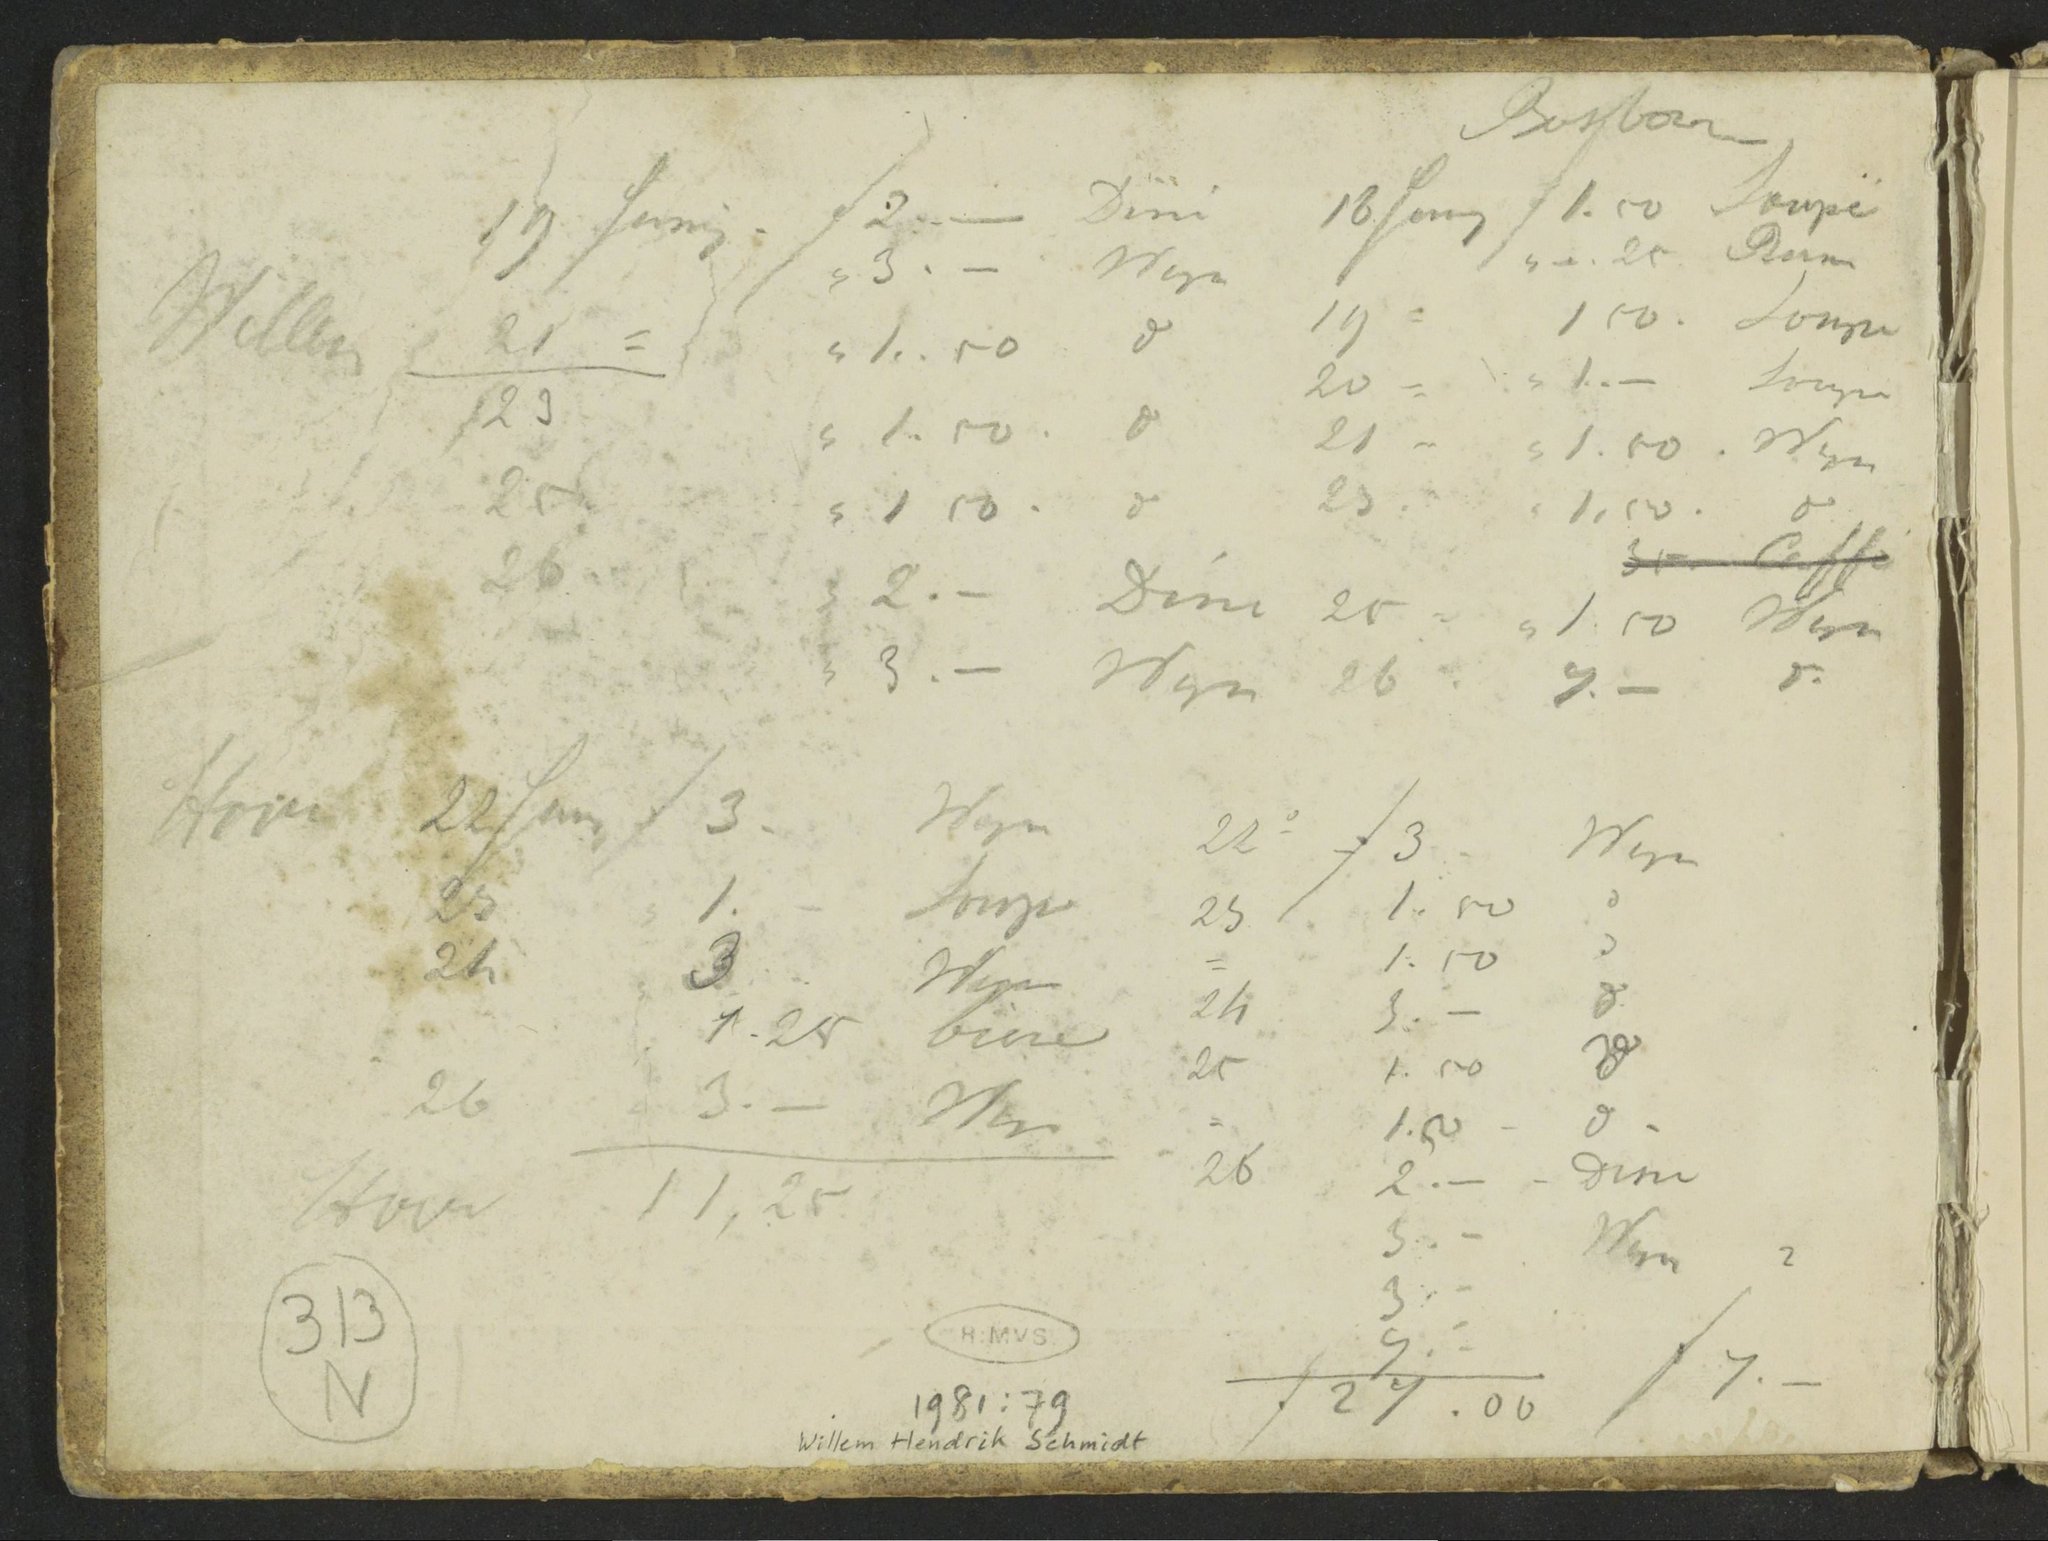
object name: sketchbook leaf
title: Declaraties van de kunstenaar, Johannes Bosboom en Bart van Hove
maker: willem hendrik schmidt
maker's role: draughtsman, painter, print maker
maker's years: 1809-1849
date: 1819-1849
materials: paper, pencil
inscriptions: annotation: ‘Willem 19 Junij f 2,- Diné/ Bosboom/ 18 Junij f1.50 Soupé/ Hove 22 Jun f3 3- wijn/ ...’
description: Voorste schutblad uit een schetsboek met 36 bladen.